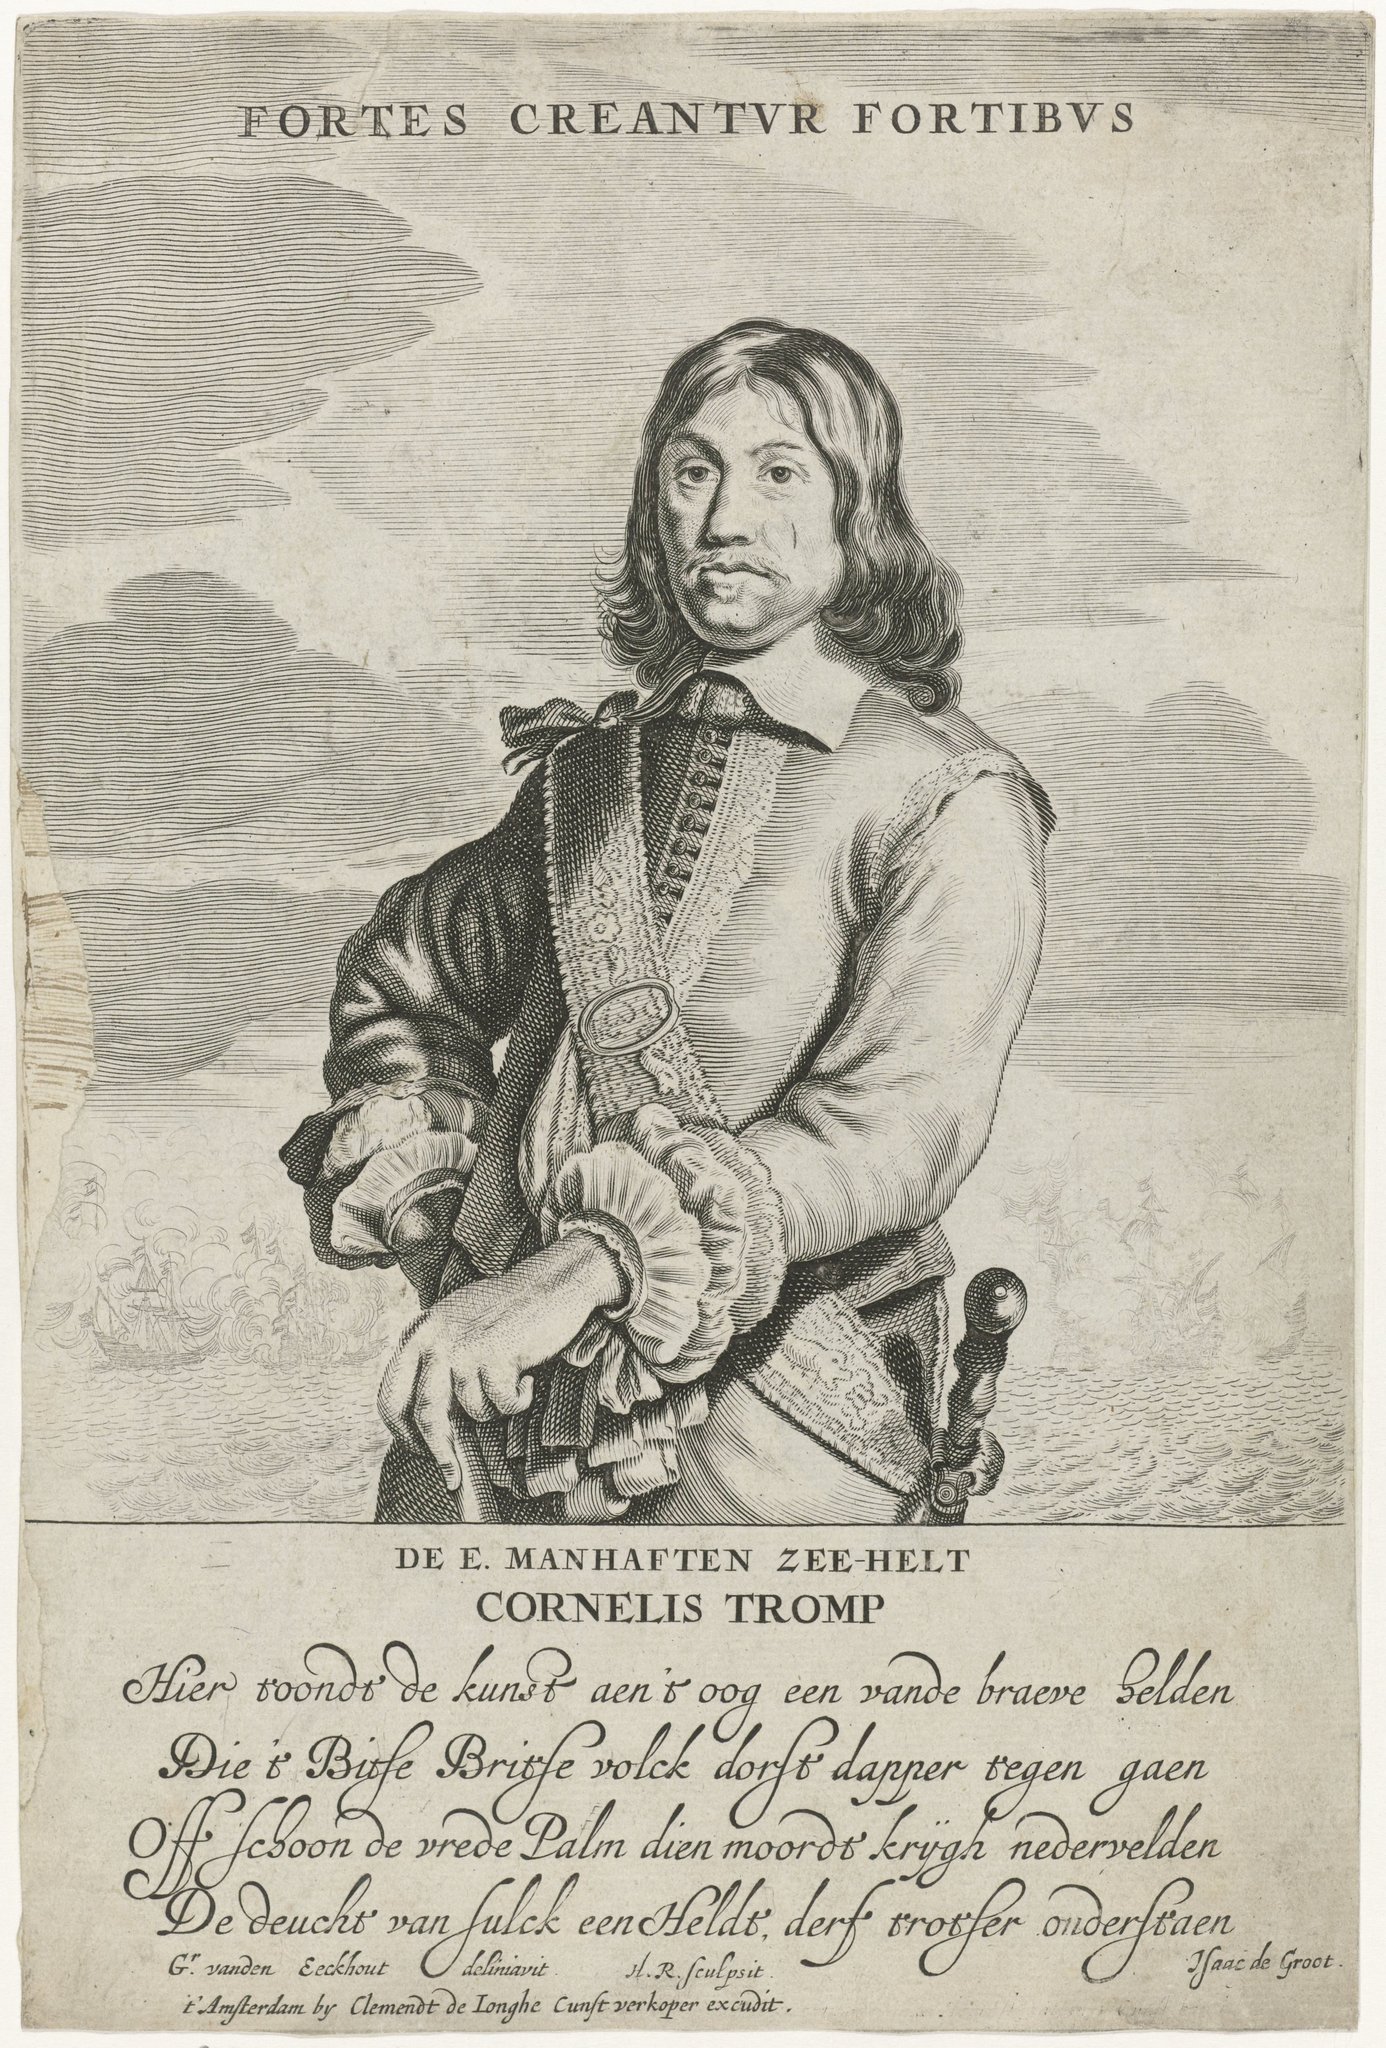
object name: print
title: Fortes Creantvr Fortibvs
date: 1649-1670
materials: paper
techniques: engraving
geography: northern netherlands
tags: cornelis tromp, warfare; military affairs (+ sailing-ships), battle, fighting in general (+ naval force)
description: Portret van Cornelis Tromp, luitenant-admiraal van Holland en West-Friesland. Op de achtergrond een zeeslag. In de marge zijn naam en een lofdicht.